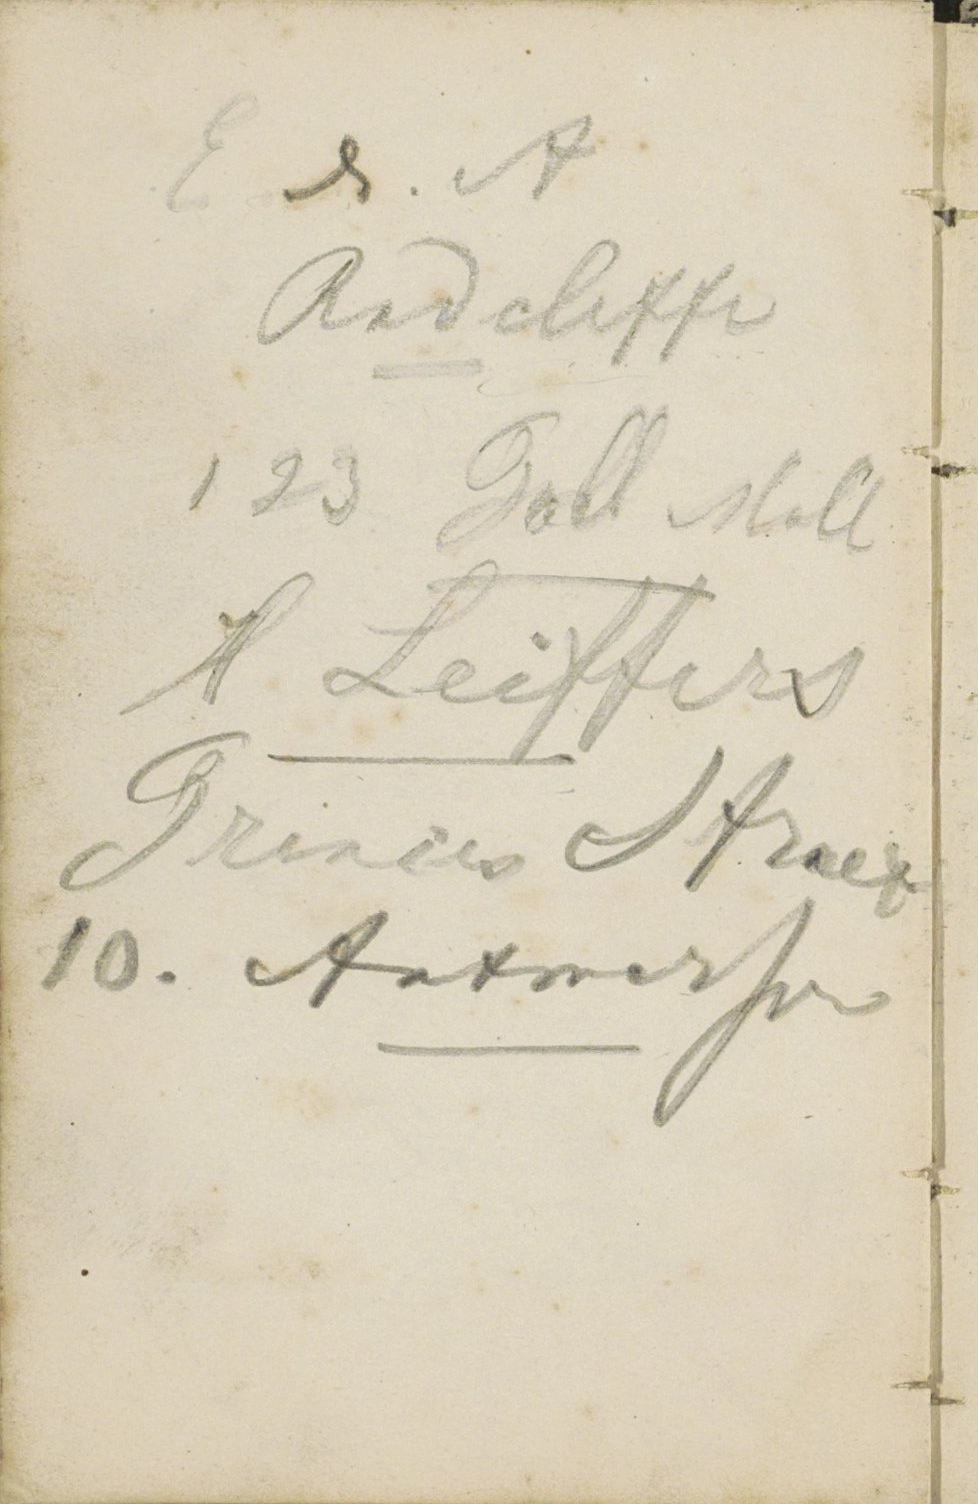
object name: sketchbook leaf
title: Adressen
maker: willem koekkoek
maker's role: draughtsman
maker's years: 1839-1895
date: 1849-1895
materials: paper, pencil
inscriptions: annotation: ‘E.s.A/ Radcliffe/ 123 [...] Hall/ A Leiffers/ [...]in[...] Street/ 10 Antwerpen’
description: Blad 57 verso uit een schetsboek met 57 bladen.